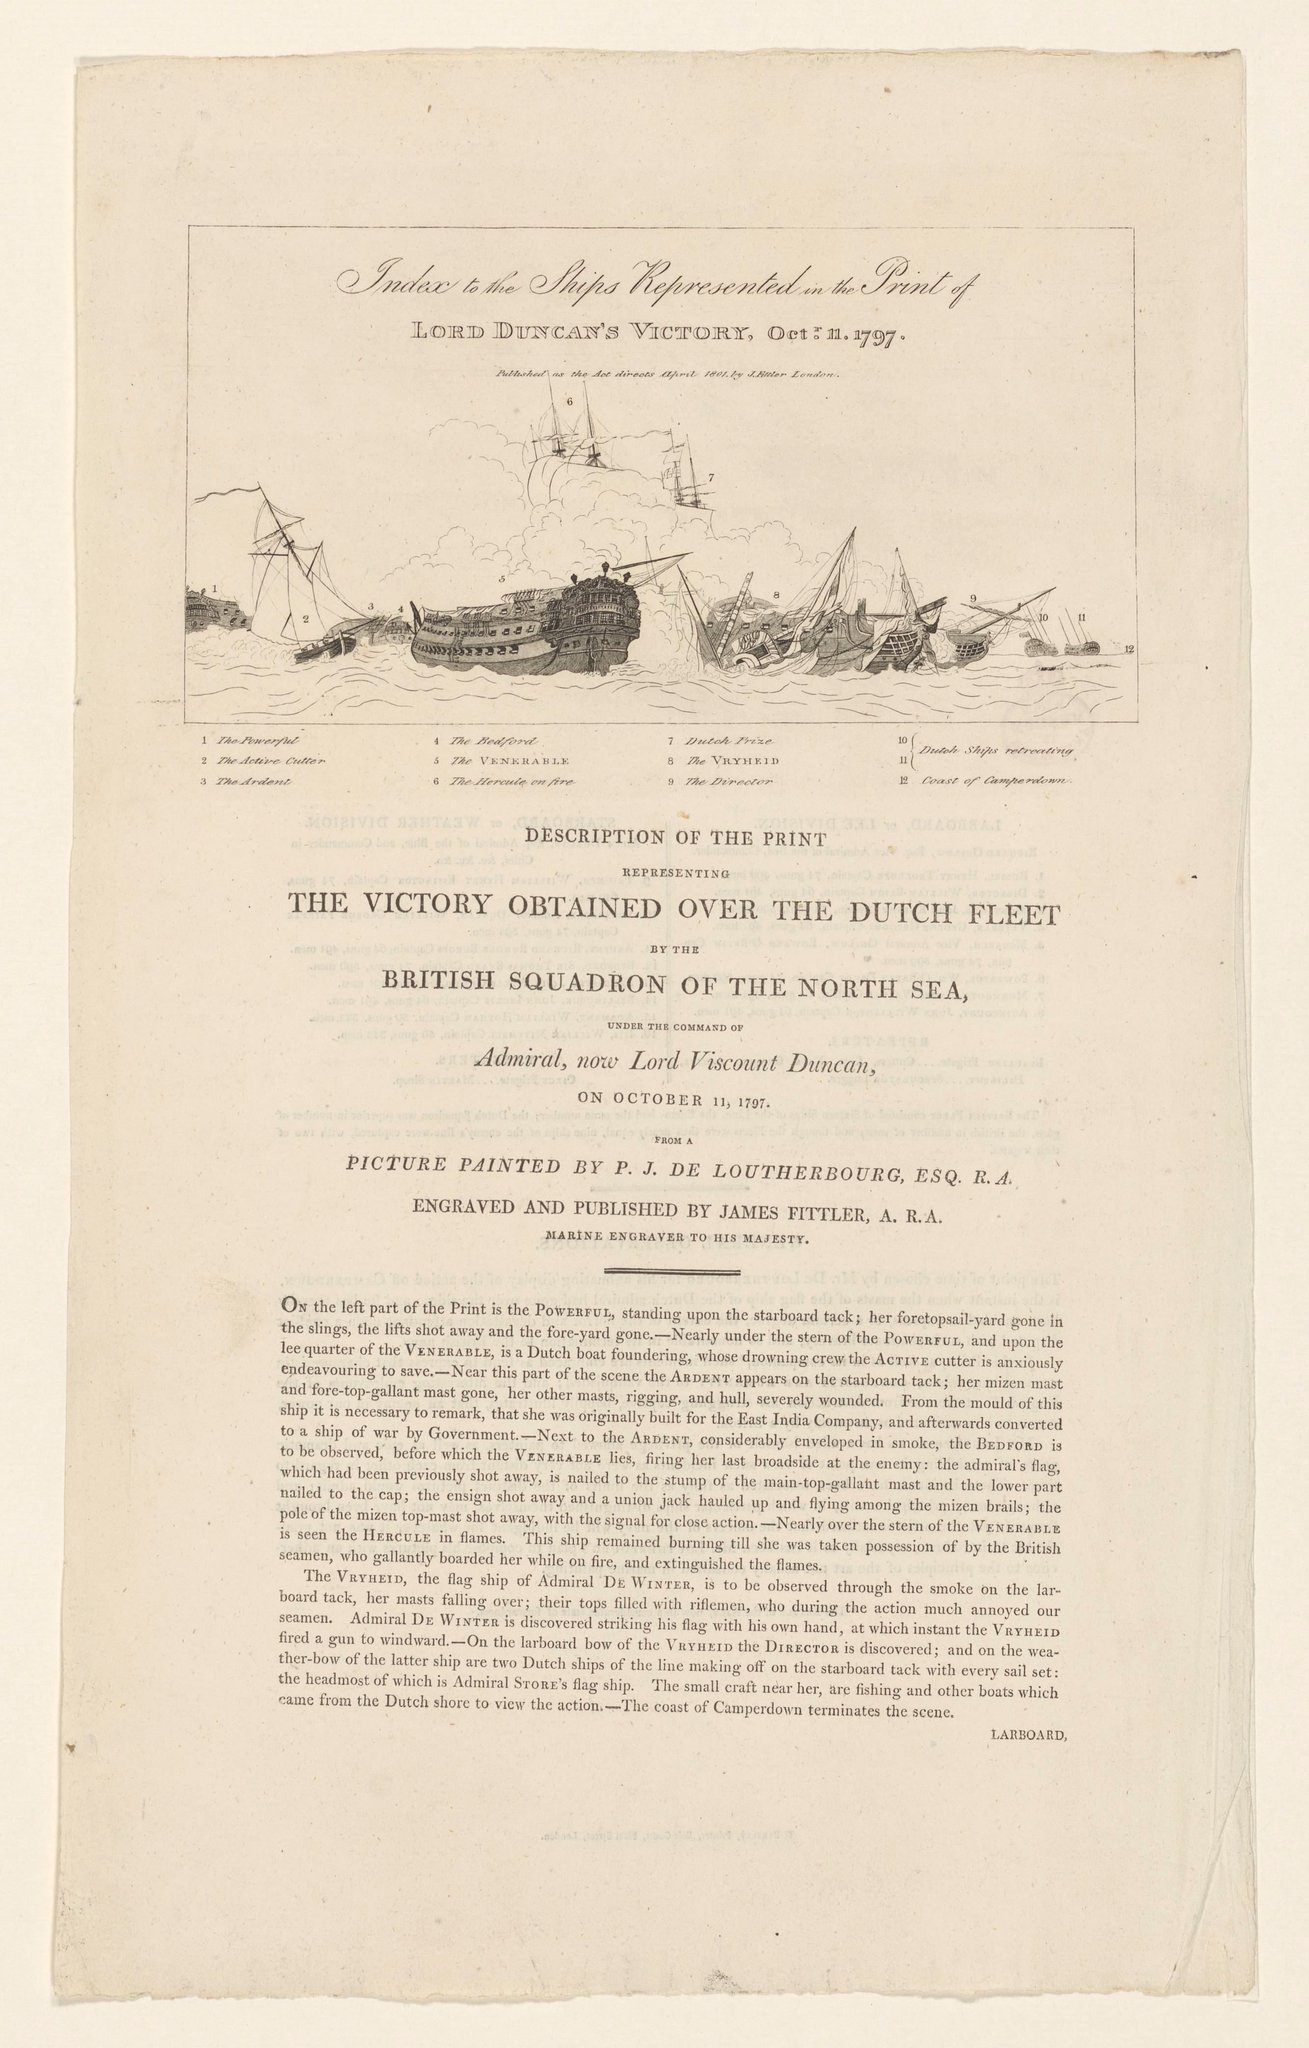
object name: text sheet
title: Sleutel bij de prent van de slag bij Kamperduin, 1797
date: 1801-1804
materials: paper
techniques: etching, letterpress printing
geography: london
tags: adam duncan (burggraaf van duncan), paris, jan willem de winter, battle (+ naval force), battle of camperdown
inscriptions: collector's mark: Lugt 12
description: Sleutel en beschrijving van de prent van de Britse overwinning in de zeeslag bij Kamperduin op 11 oktober 1797 tussen de Bataafse vloot onder bevel van vice-admiraal Jan Willem de Winter en een Britse vloot onder admiraal Adam Duncan. Blad bedrukt op beide zijden met tekst, op de voorzijde bovenaan een schematische voorstelling van de zeeslag met een legenda 1-12 met de namen van de schepen.